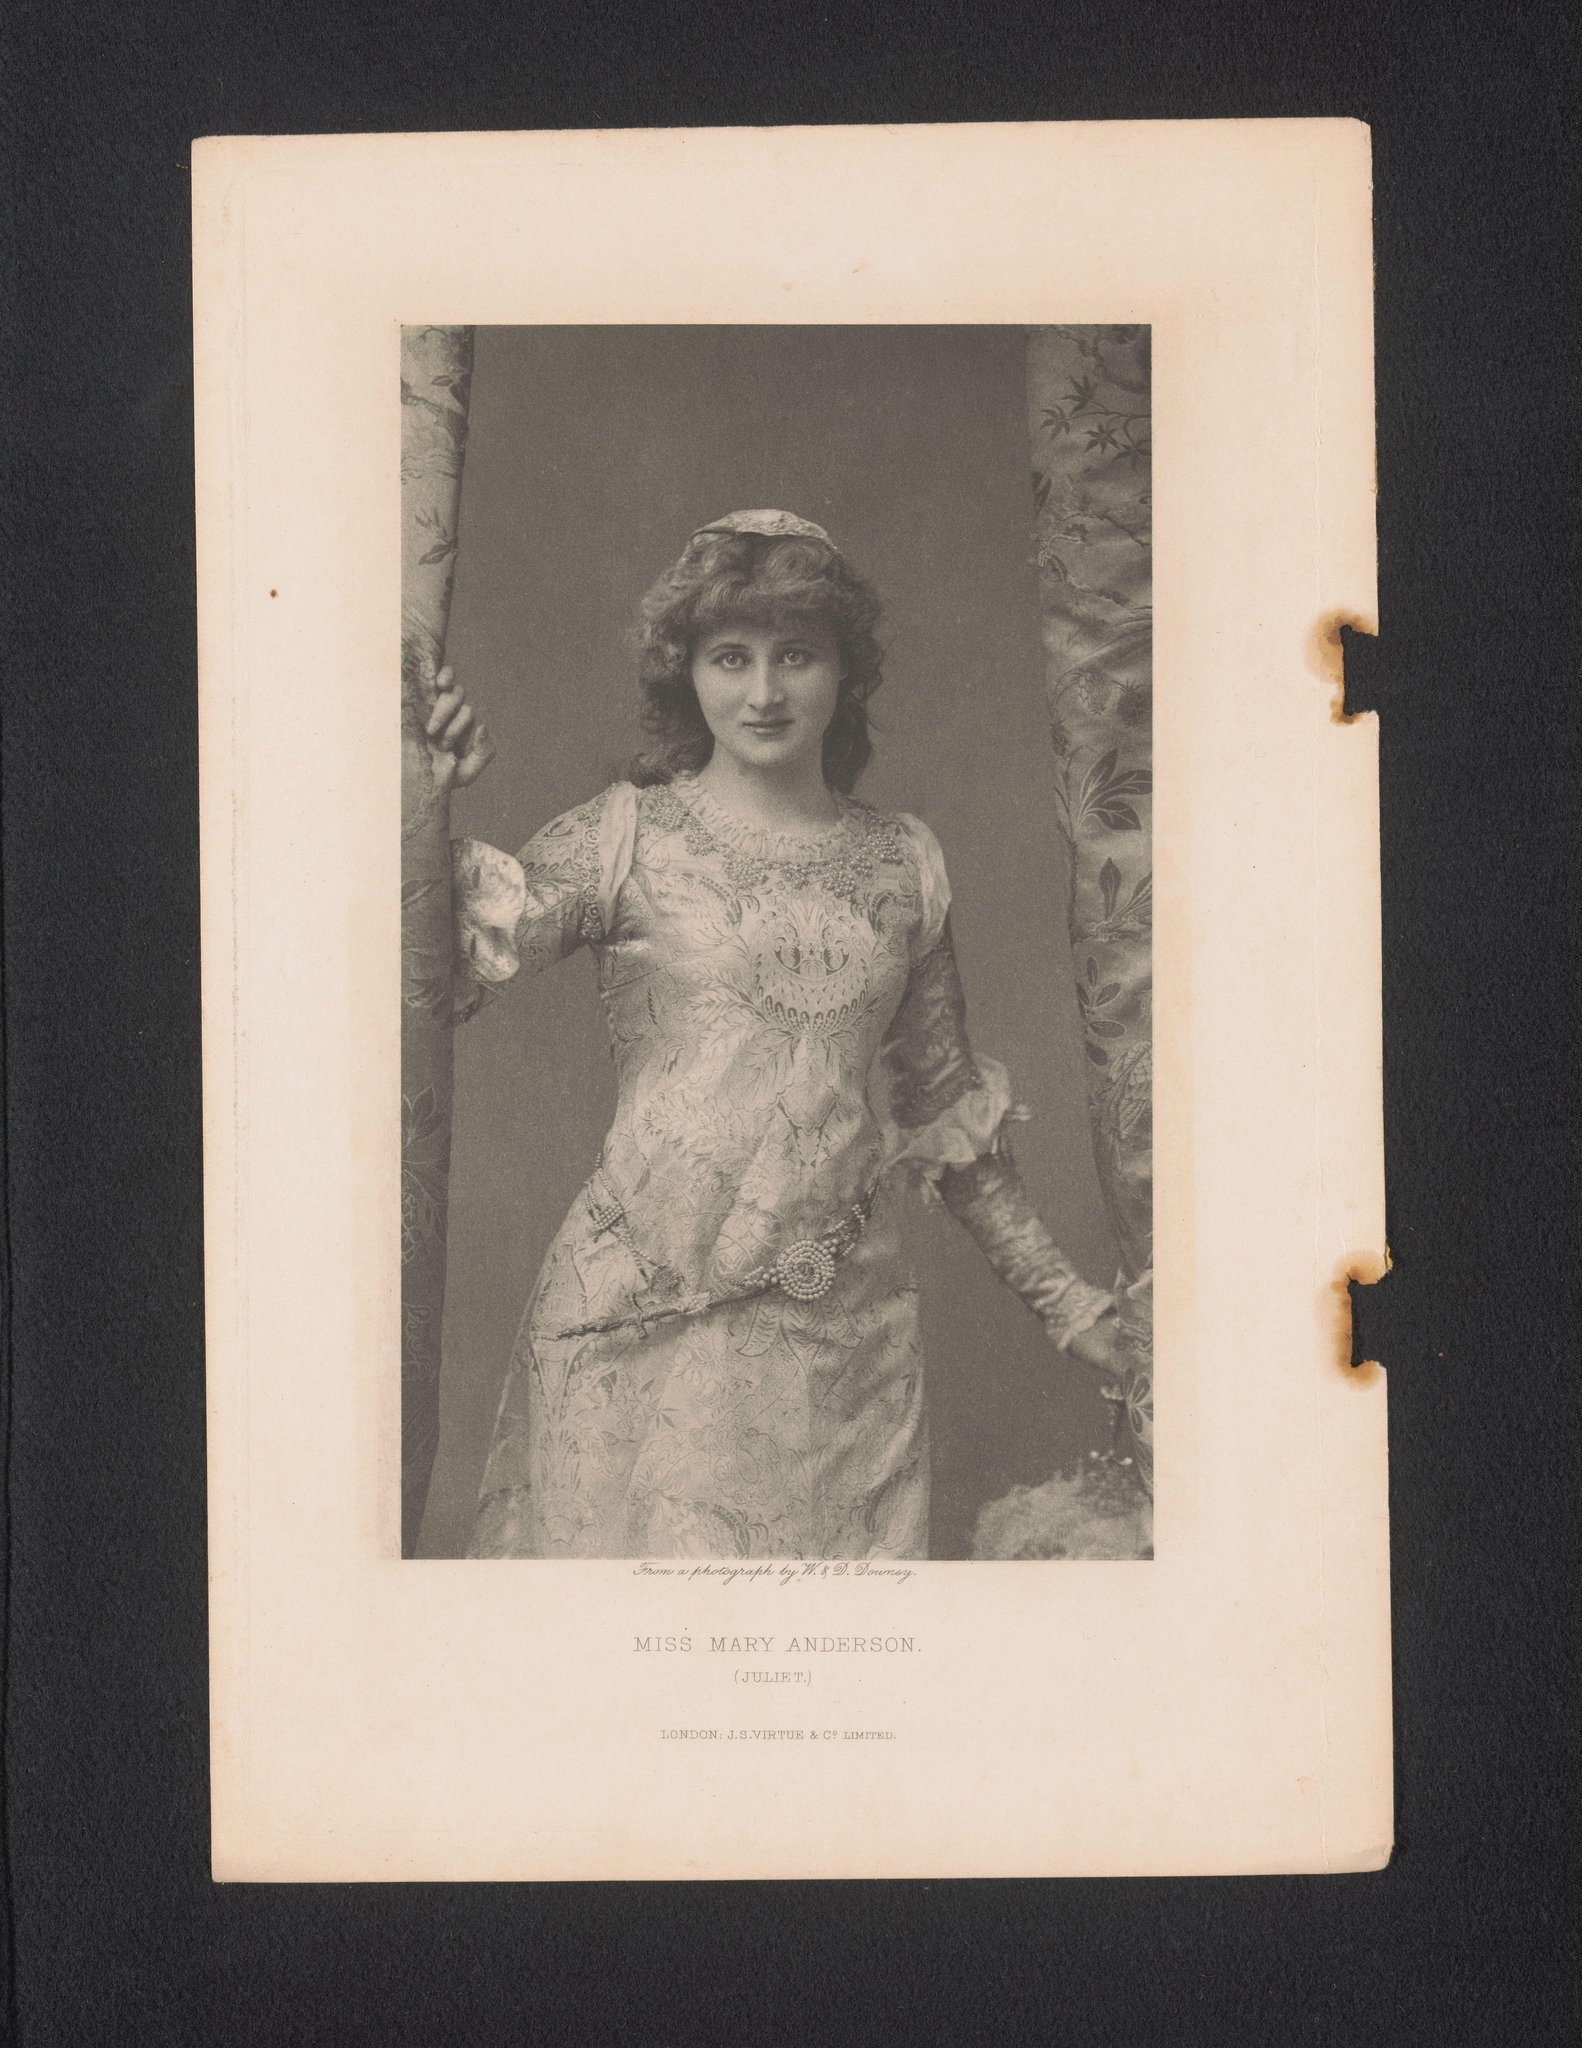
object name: photomechanical print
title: Miss Mary Anderson (Juliet)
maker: Anonymous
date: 1880-1890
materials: paper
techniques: photoaquatint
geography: london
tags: portrait of actor, actress